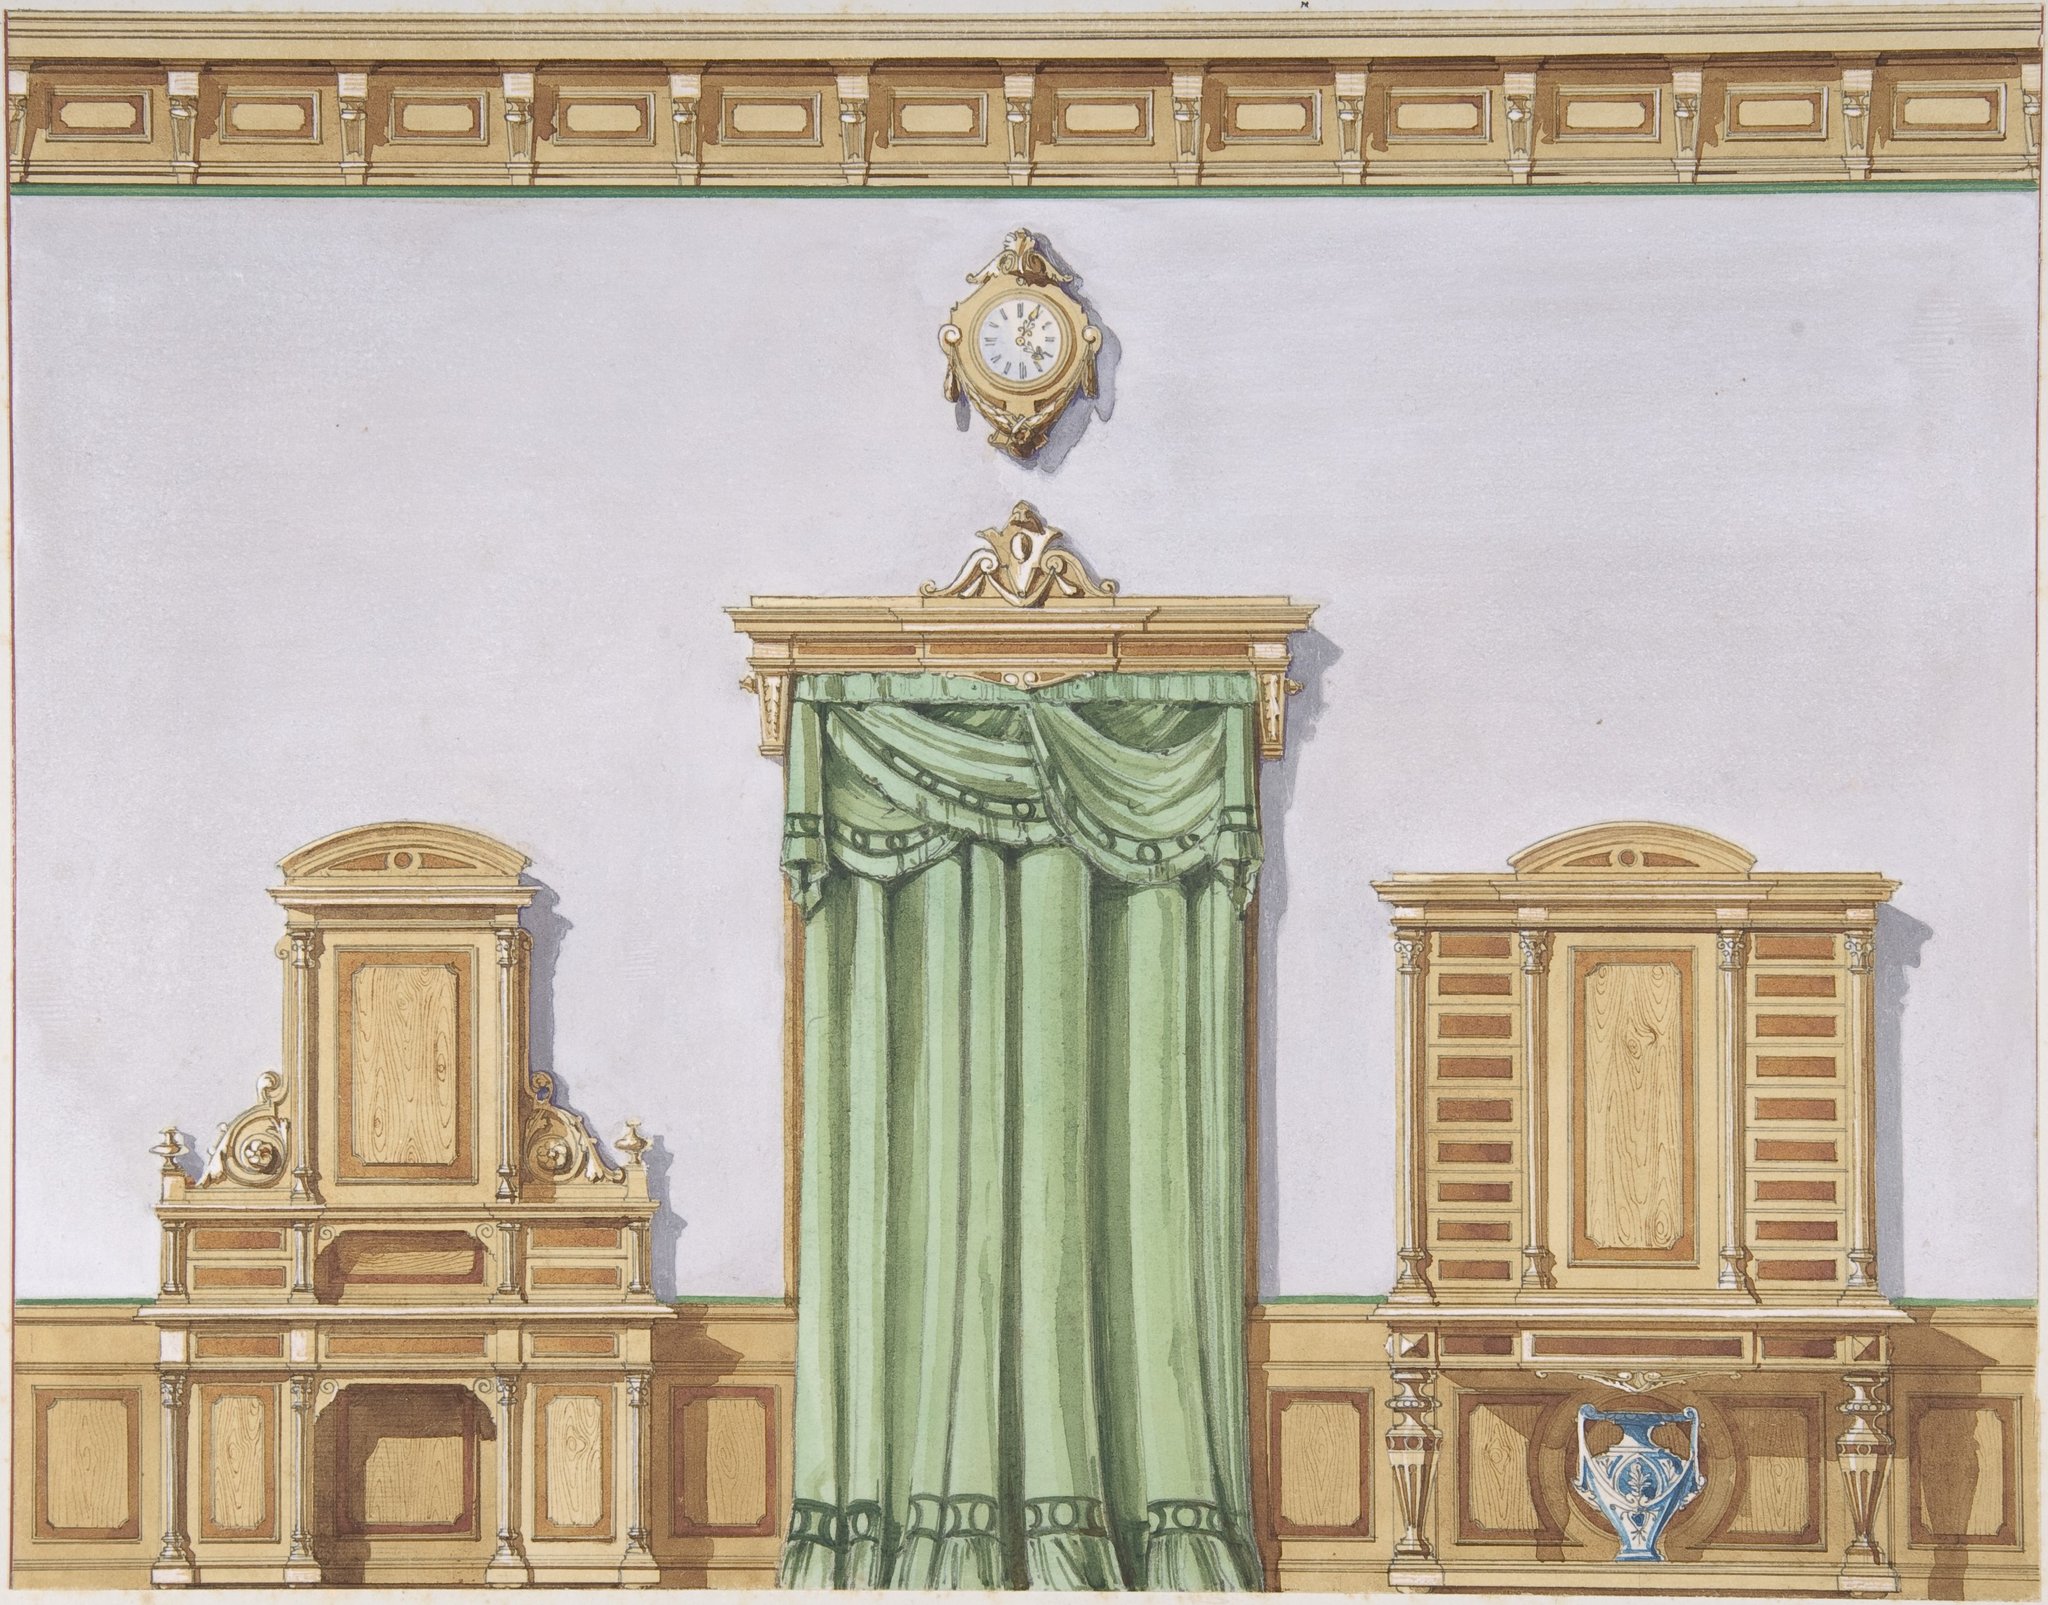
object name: drawing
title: Interior Design with a Central Door Covered by Green Drapery and Two Cabinets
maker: anonymous, british, 19th century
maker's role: artist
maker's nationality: british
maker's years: 1800-1900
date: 1867-1900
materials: gouache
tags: doors,interiors,clocks,cabinets